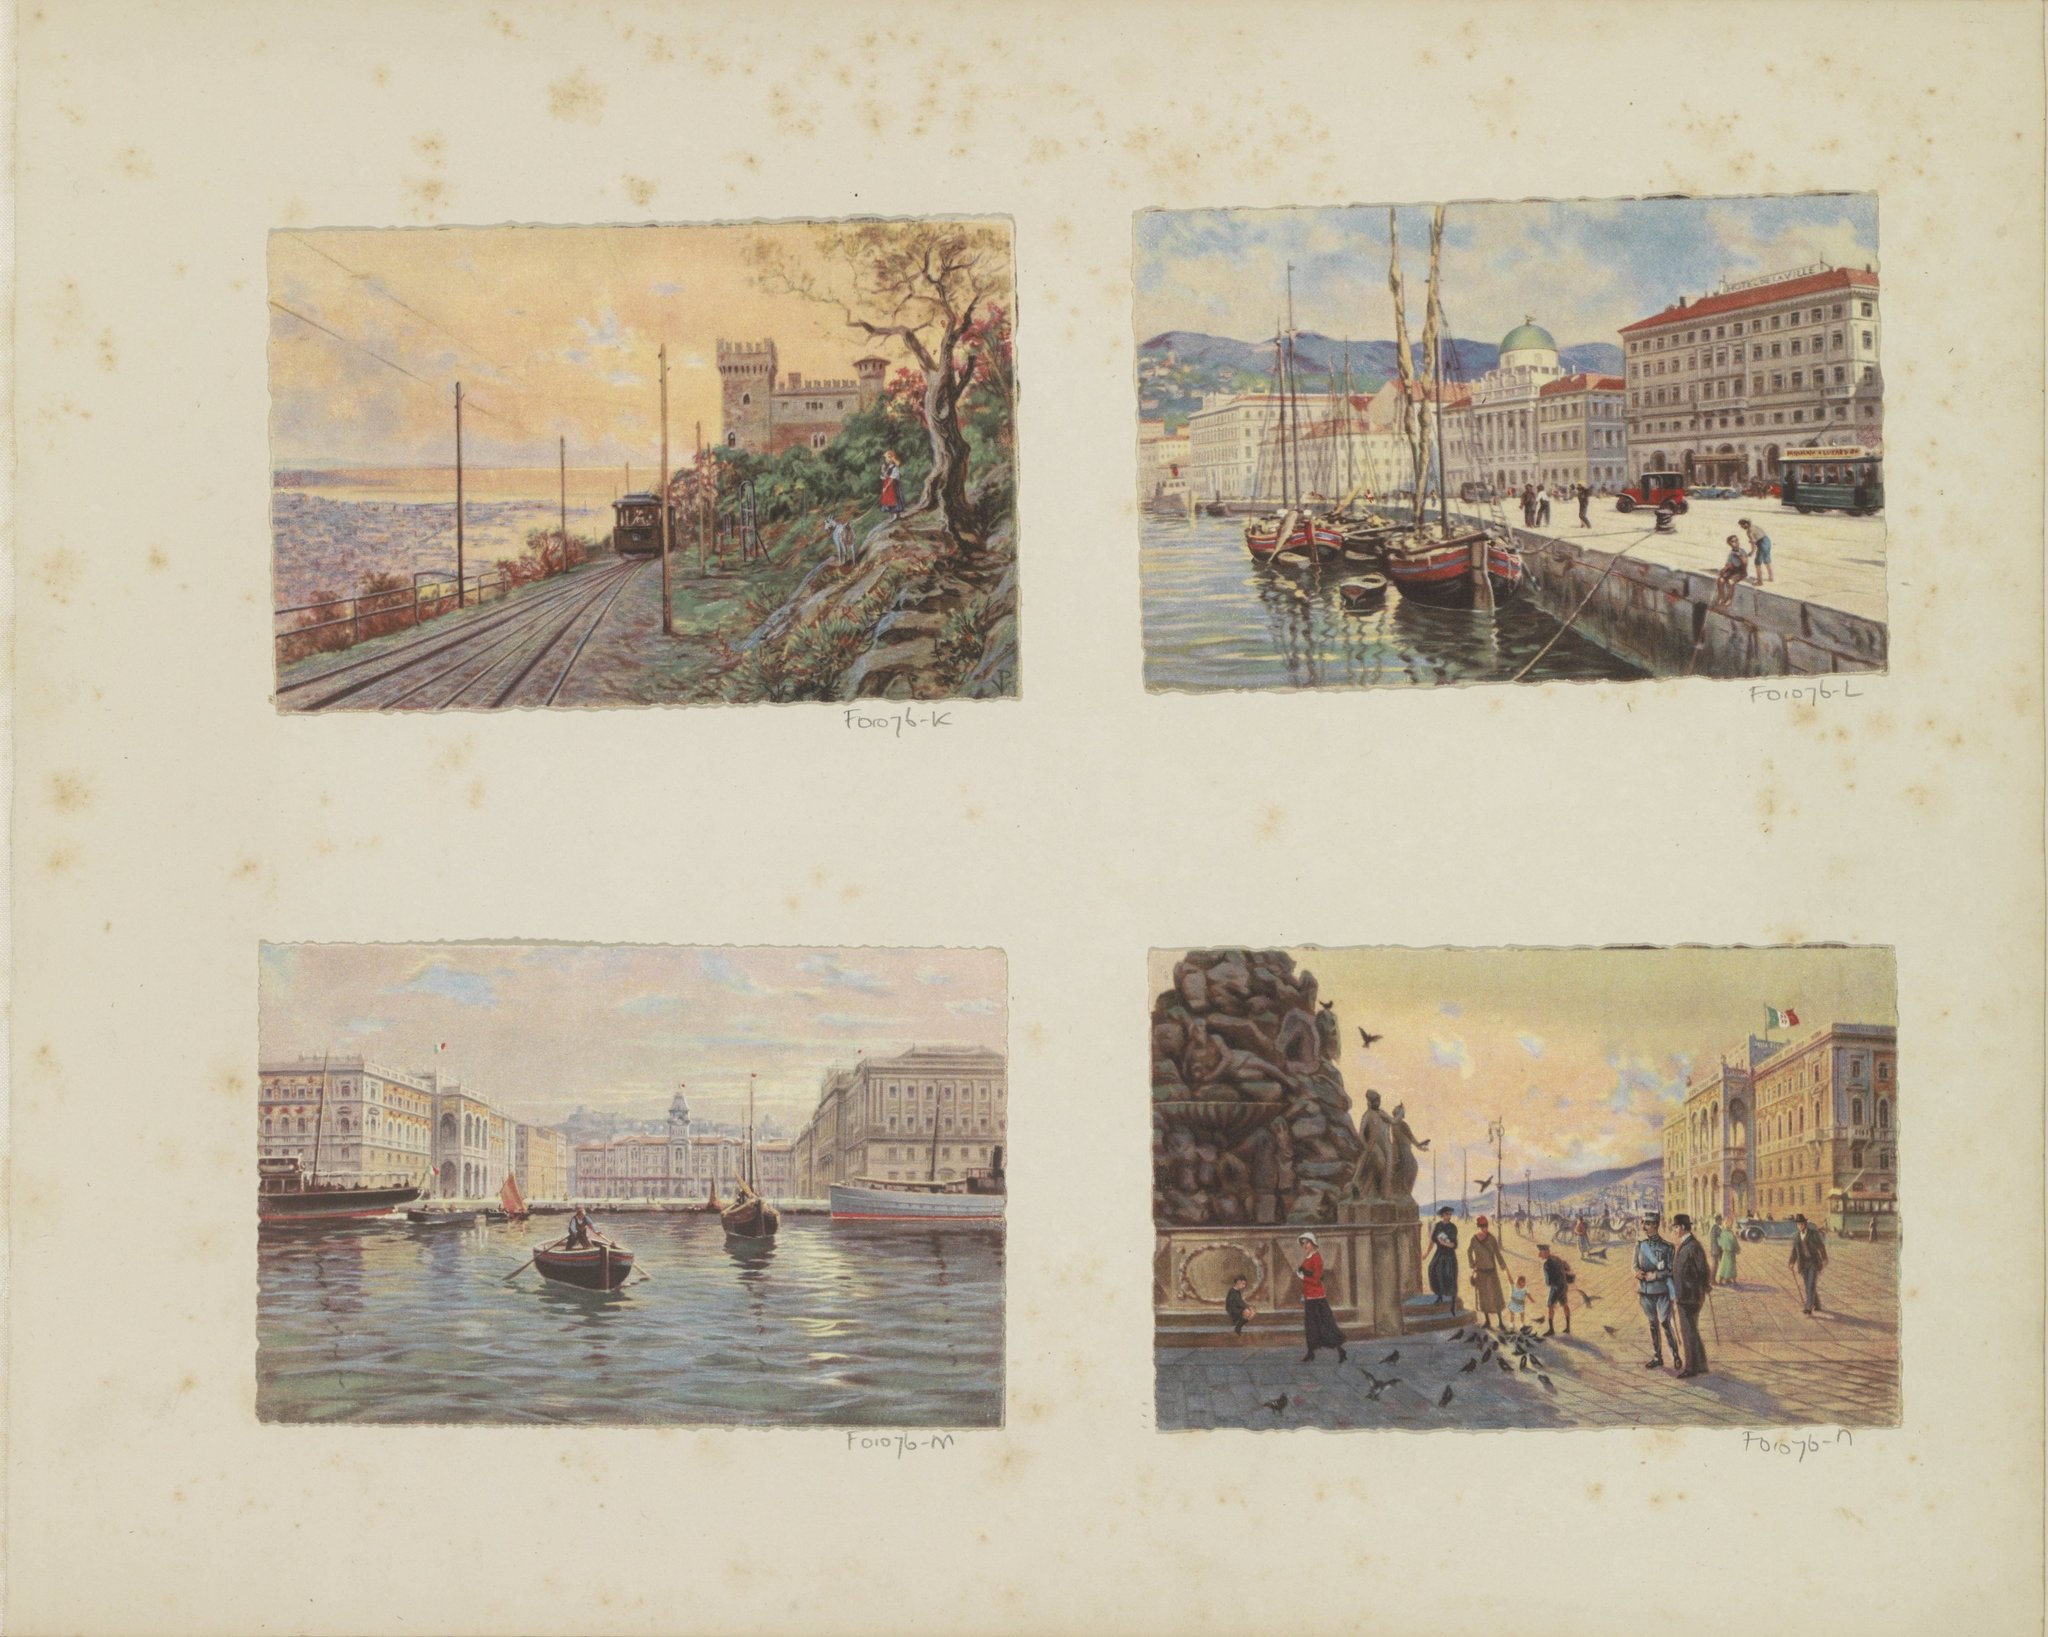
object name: ansichtkaart, prentbriefkaart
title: Fotoreproductie van (vermoedelijk) een tekening van een kade in Triëst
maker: Anonymous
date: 1900-1940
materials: cardboard, paper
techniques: offset printed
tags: quay (+ city(-scape) with figures, staffage)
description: Onderdeel van Album met foto's van spoorwegen in Nederlands-Indië en prentbriefkaarten.